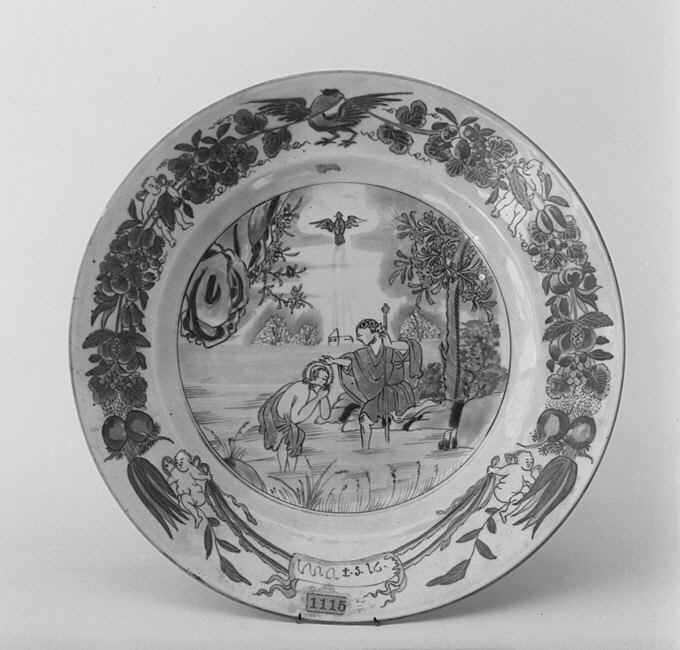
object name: plate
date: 1730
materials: hard paste porcelain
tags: birds,men,praying